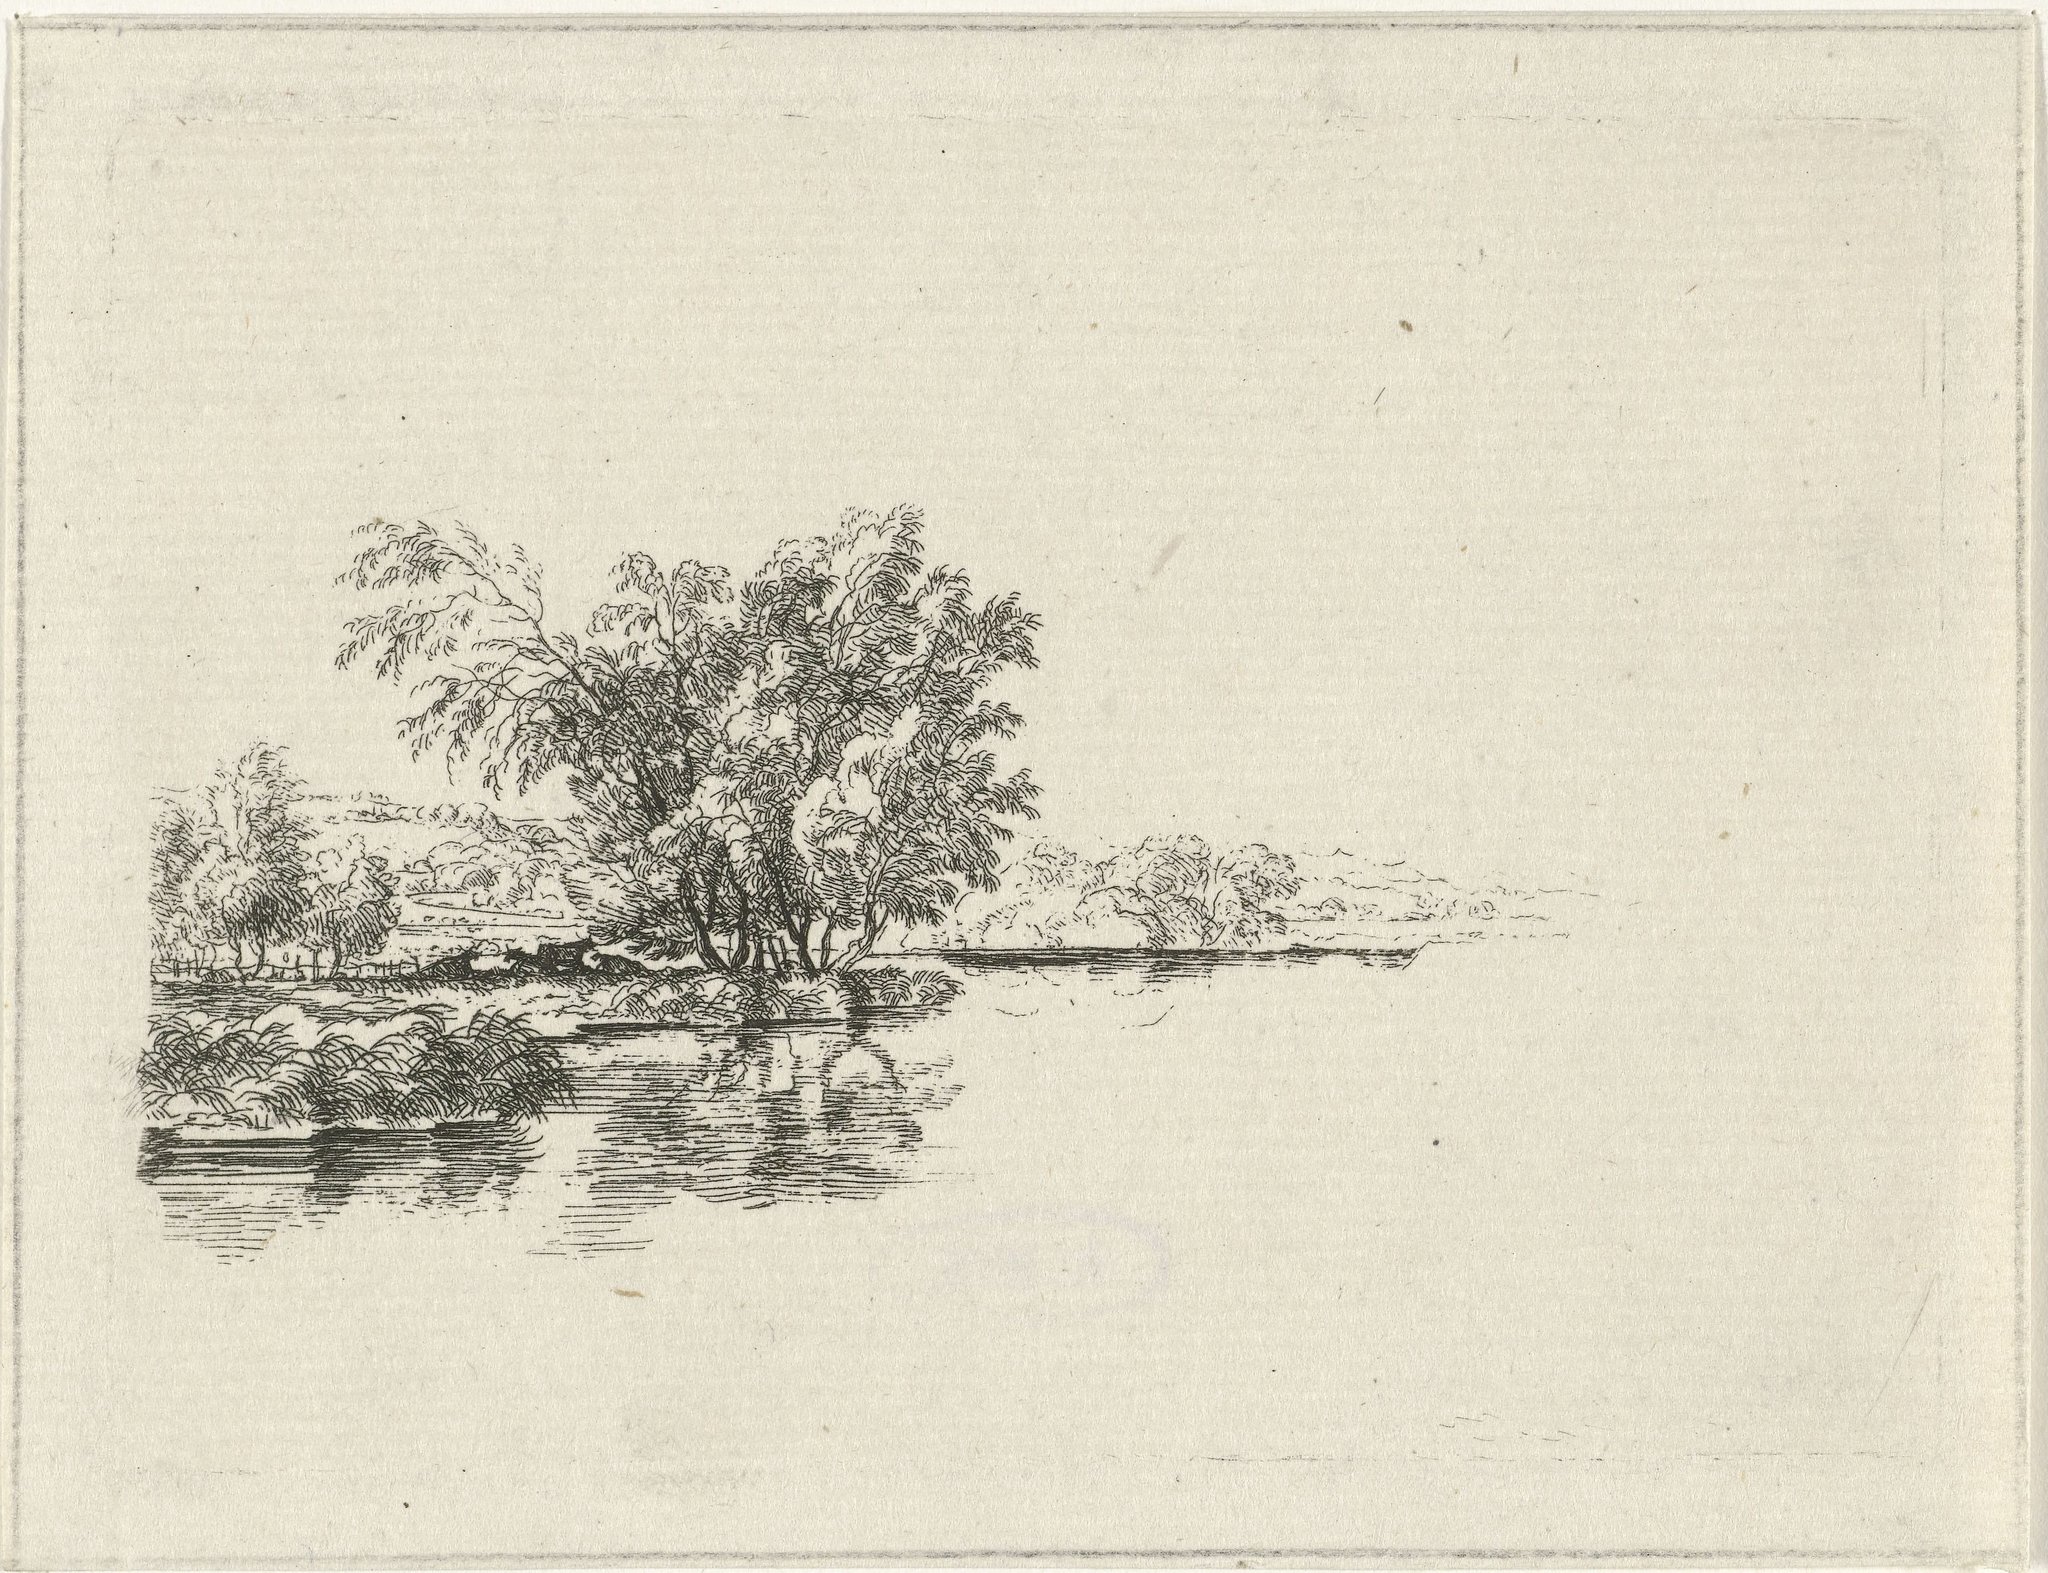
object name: print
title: Waterpartij met koeien onder de bomen langs de oever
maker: hermanus fock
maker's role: conservator, draughtsman, painter, print maker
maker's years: 1766-1822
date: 1781-1822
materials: paper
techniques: etching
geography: amsterdam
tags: river bank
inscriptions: collector's mark: Lugt 2228